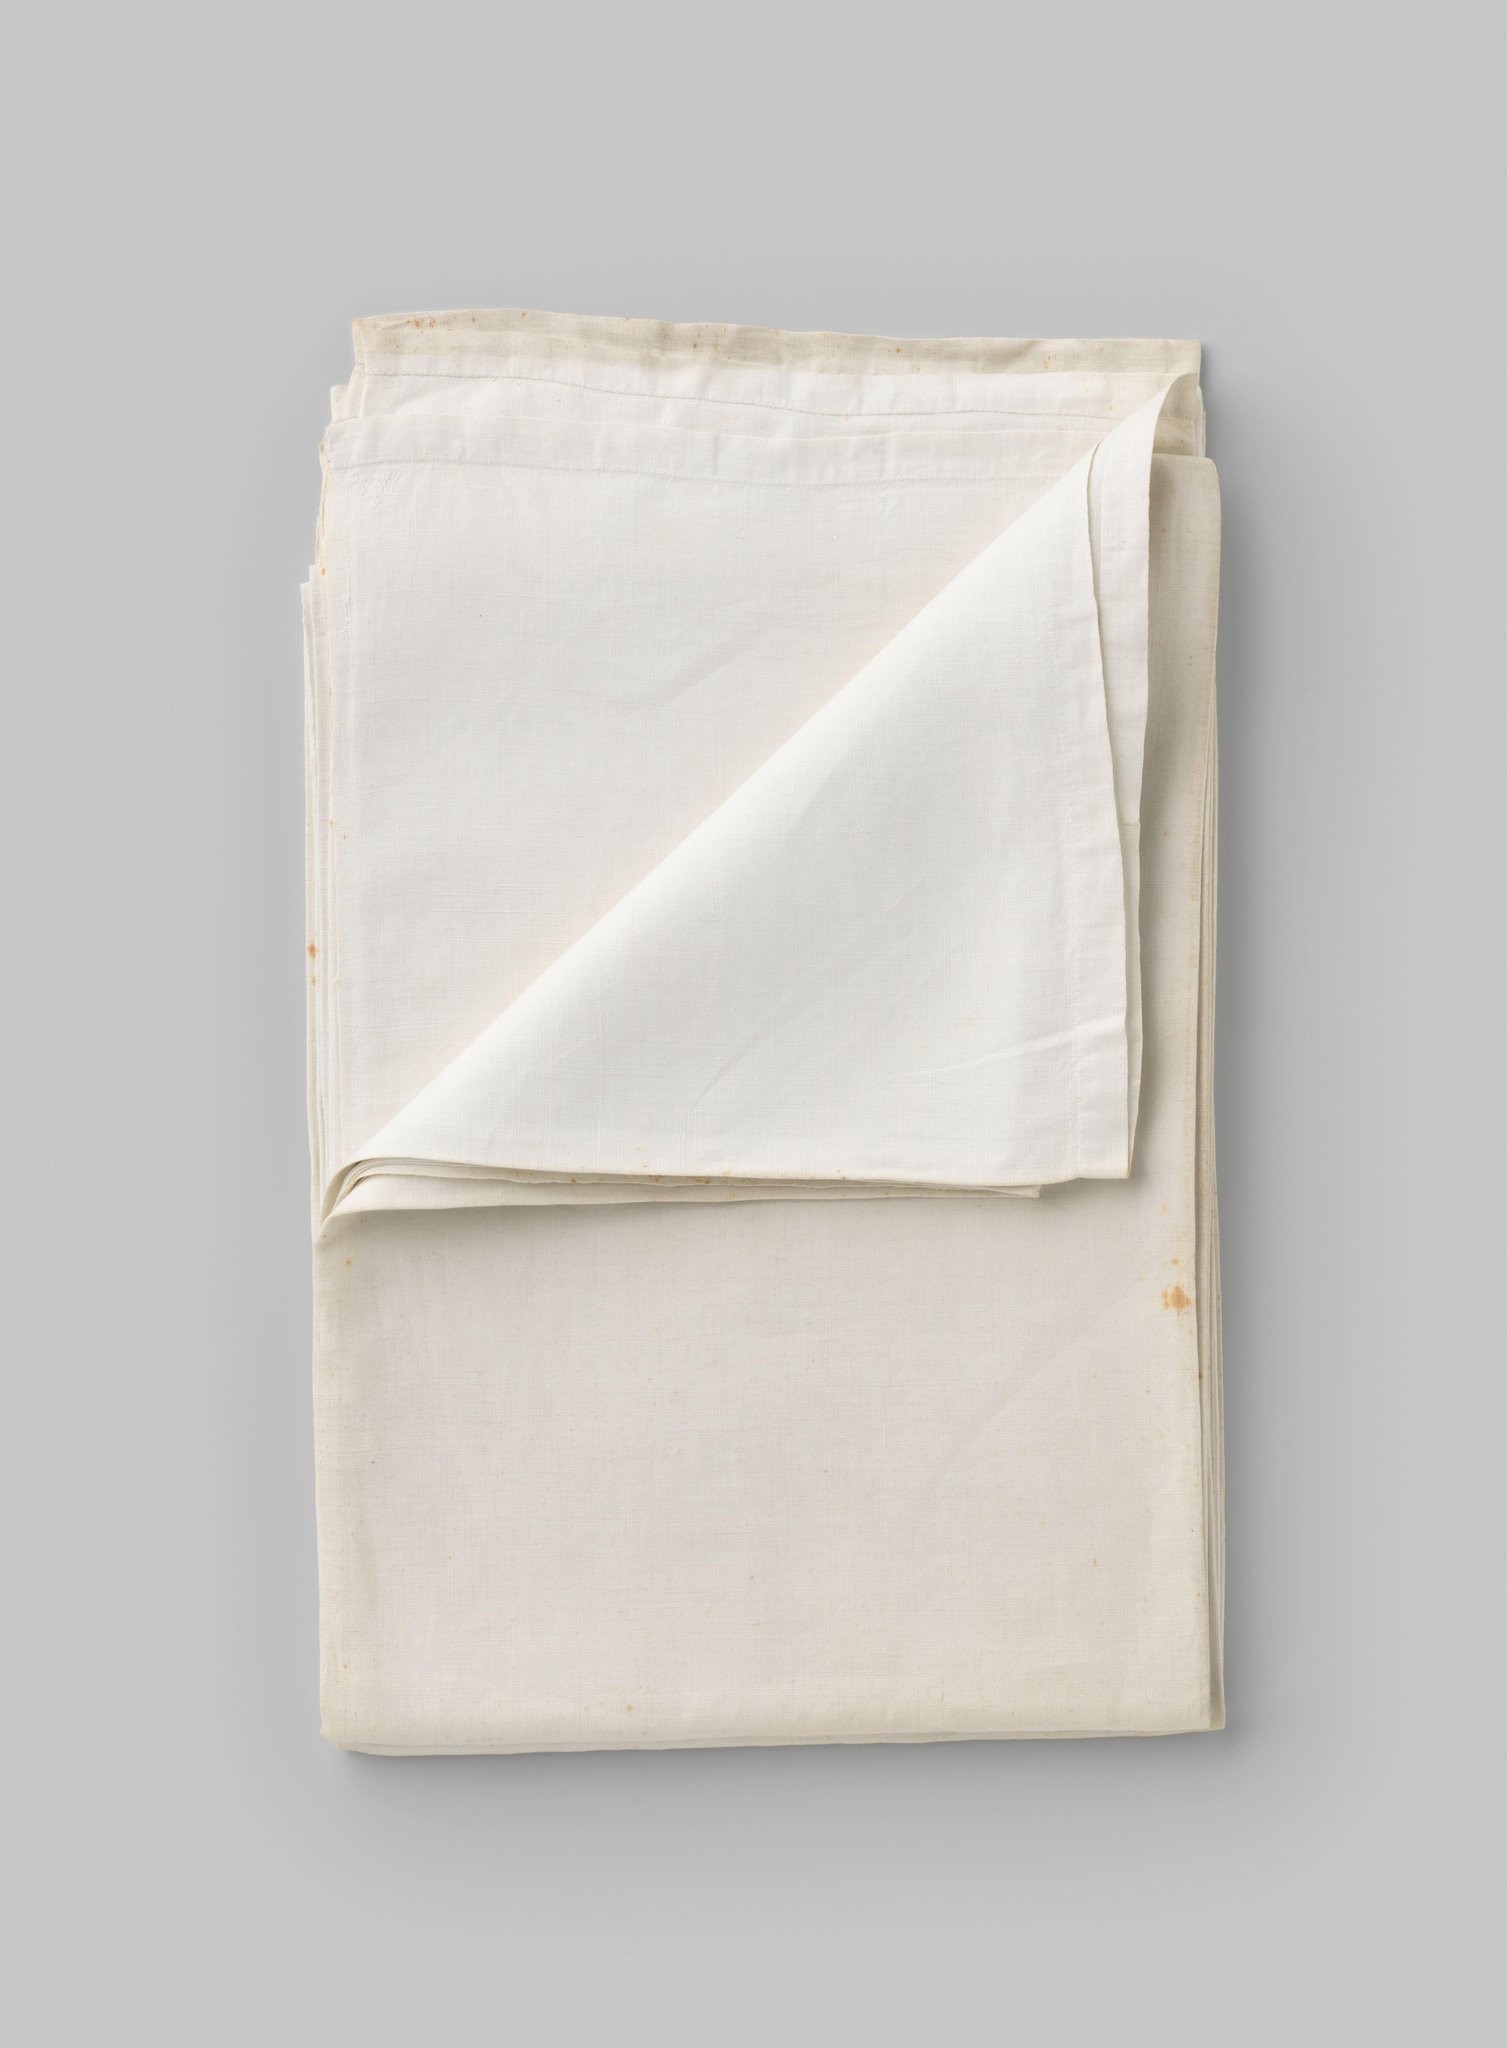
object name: beddenlaken, laken object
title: Laken. Merk: HW8.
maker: Anonymous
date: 1700-1800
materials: linen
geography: northern netherlands